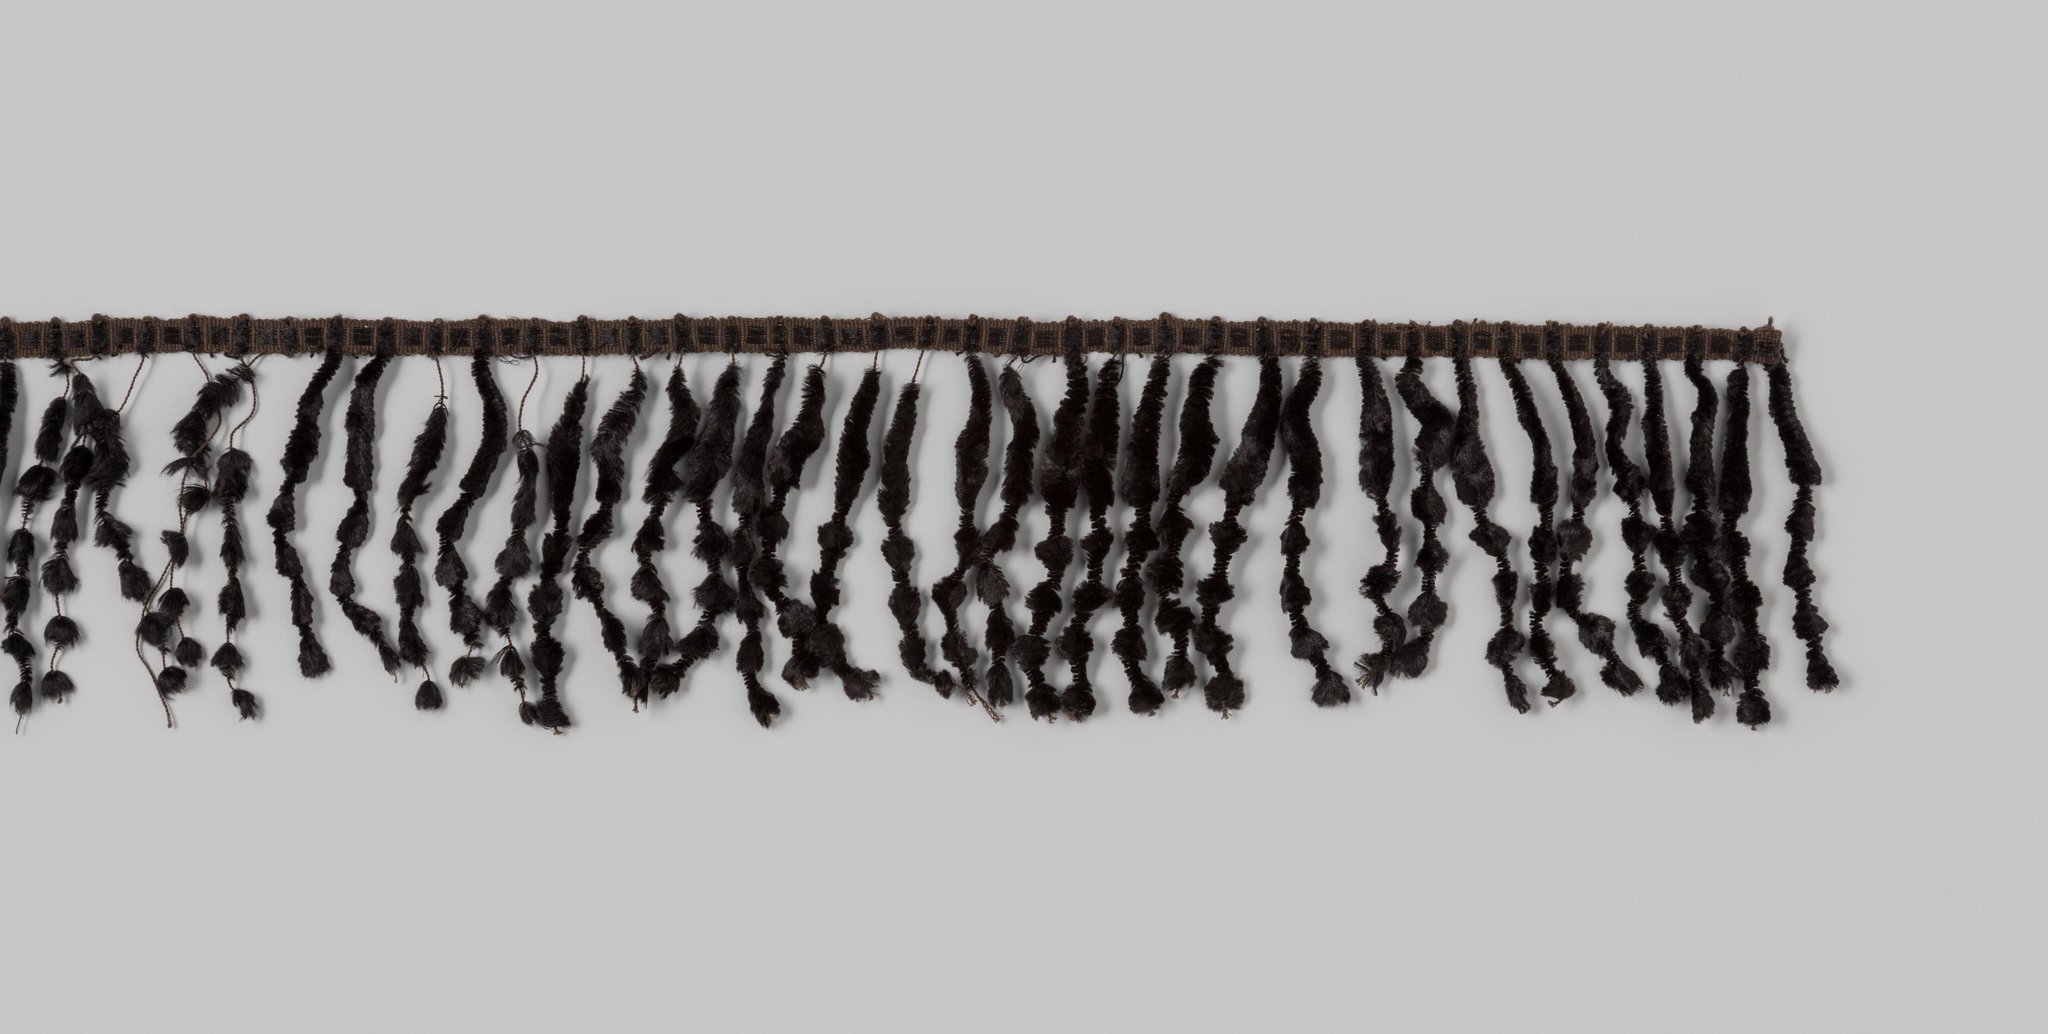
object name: braid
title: Metrage zwarte chenille-franje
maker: gustav schnitzler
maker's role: paraplufabrikant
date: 1920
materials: textile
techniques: weave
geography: france